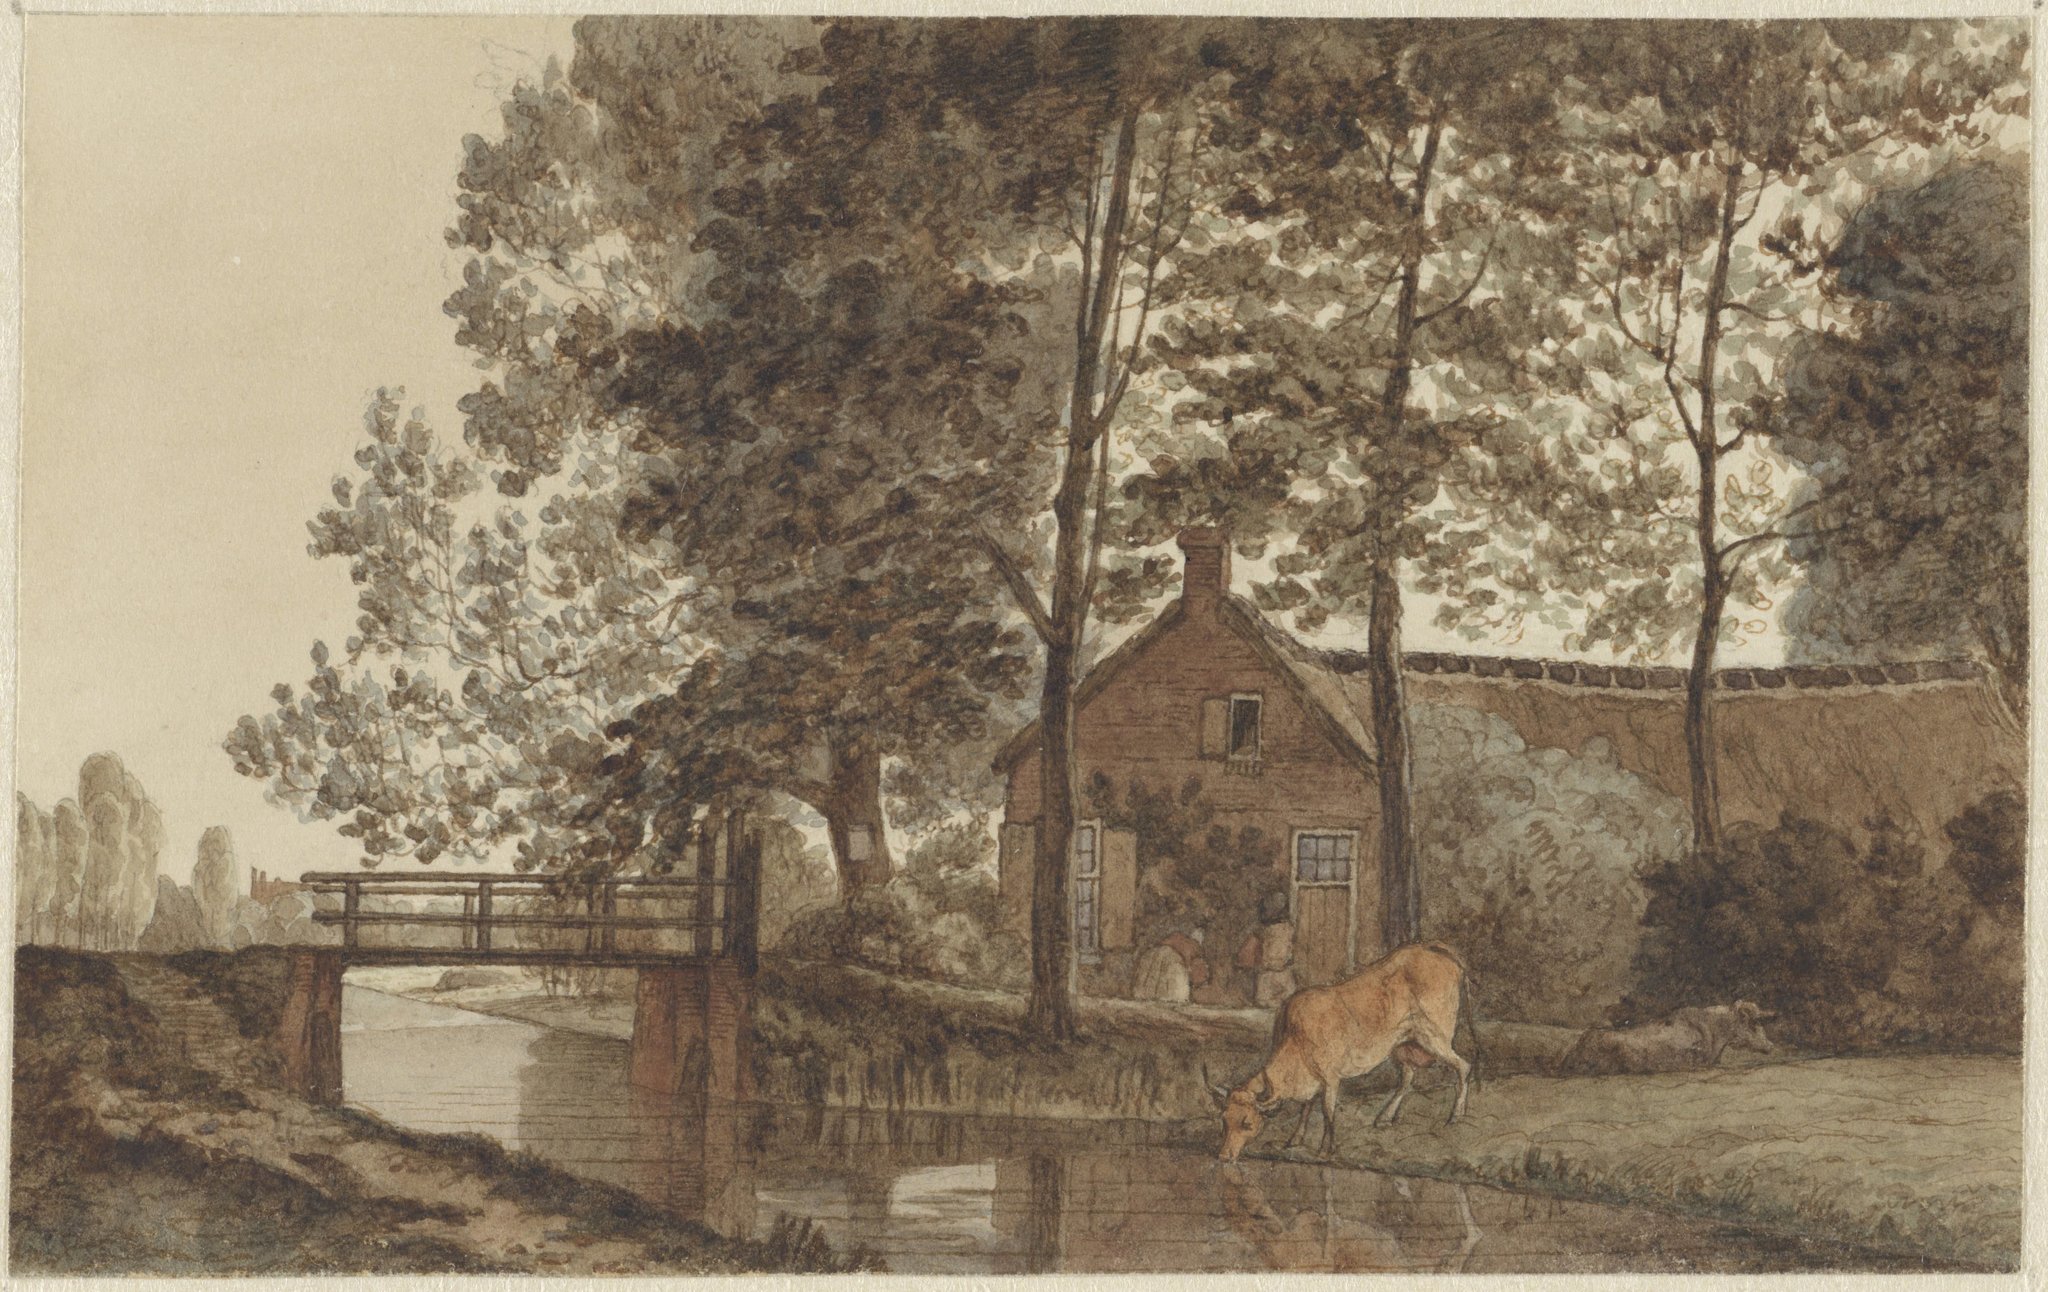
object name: drawing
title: Boerderij met drinkende koe aan de Biltstraat te Utrecht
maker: hendrik abraham klinkhamer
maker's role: draughtsman, painter, print maker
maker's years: 1810-1872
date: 1856-1858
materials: ink, paper, pencil, watercolor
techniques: brush, pen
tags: cow, farm or solitary house in landscape, utrecht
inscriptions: inscription: ‘Aan de Bildstraat over Zomerlust’